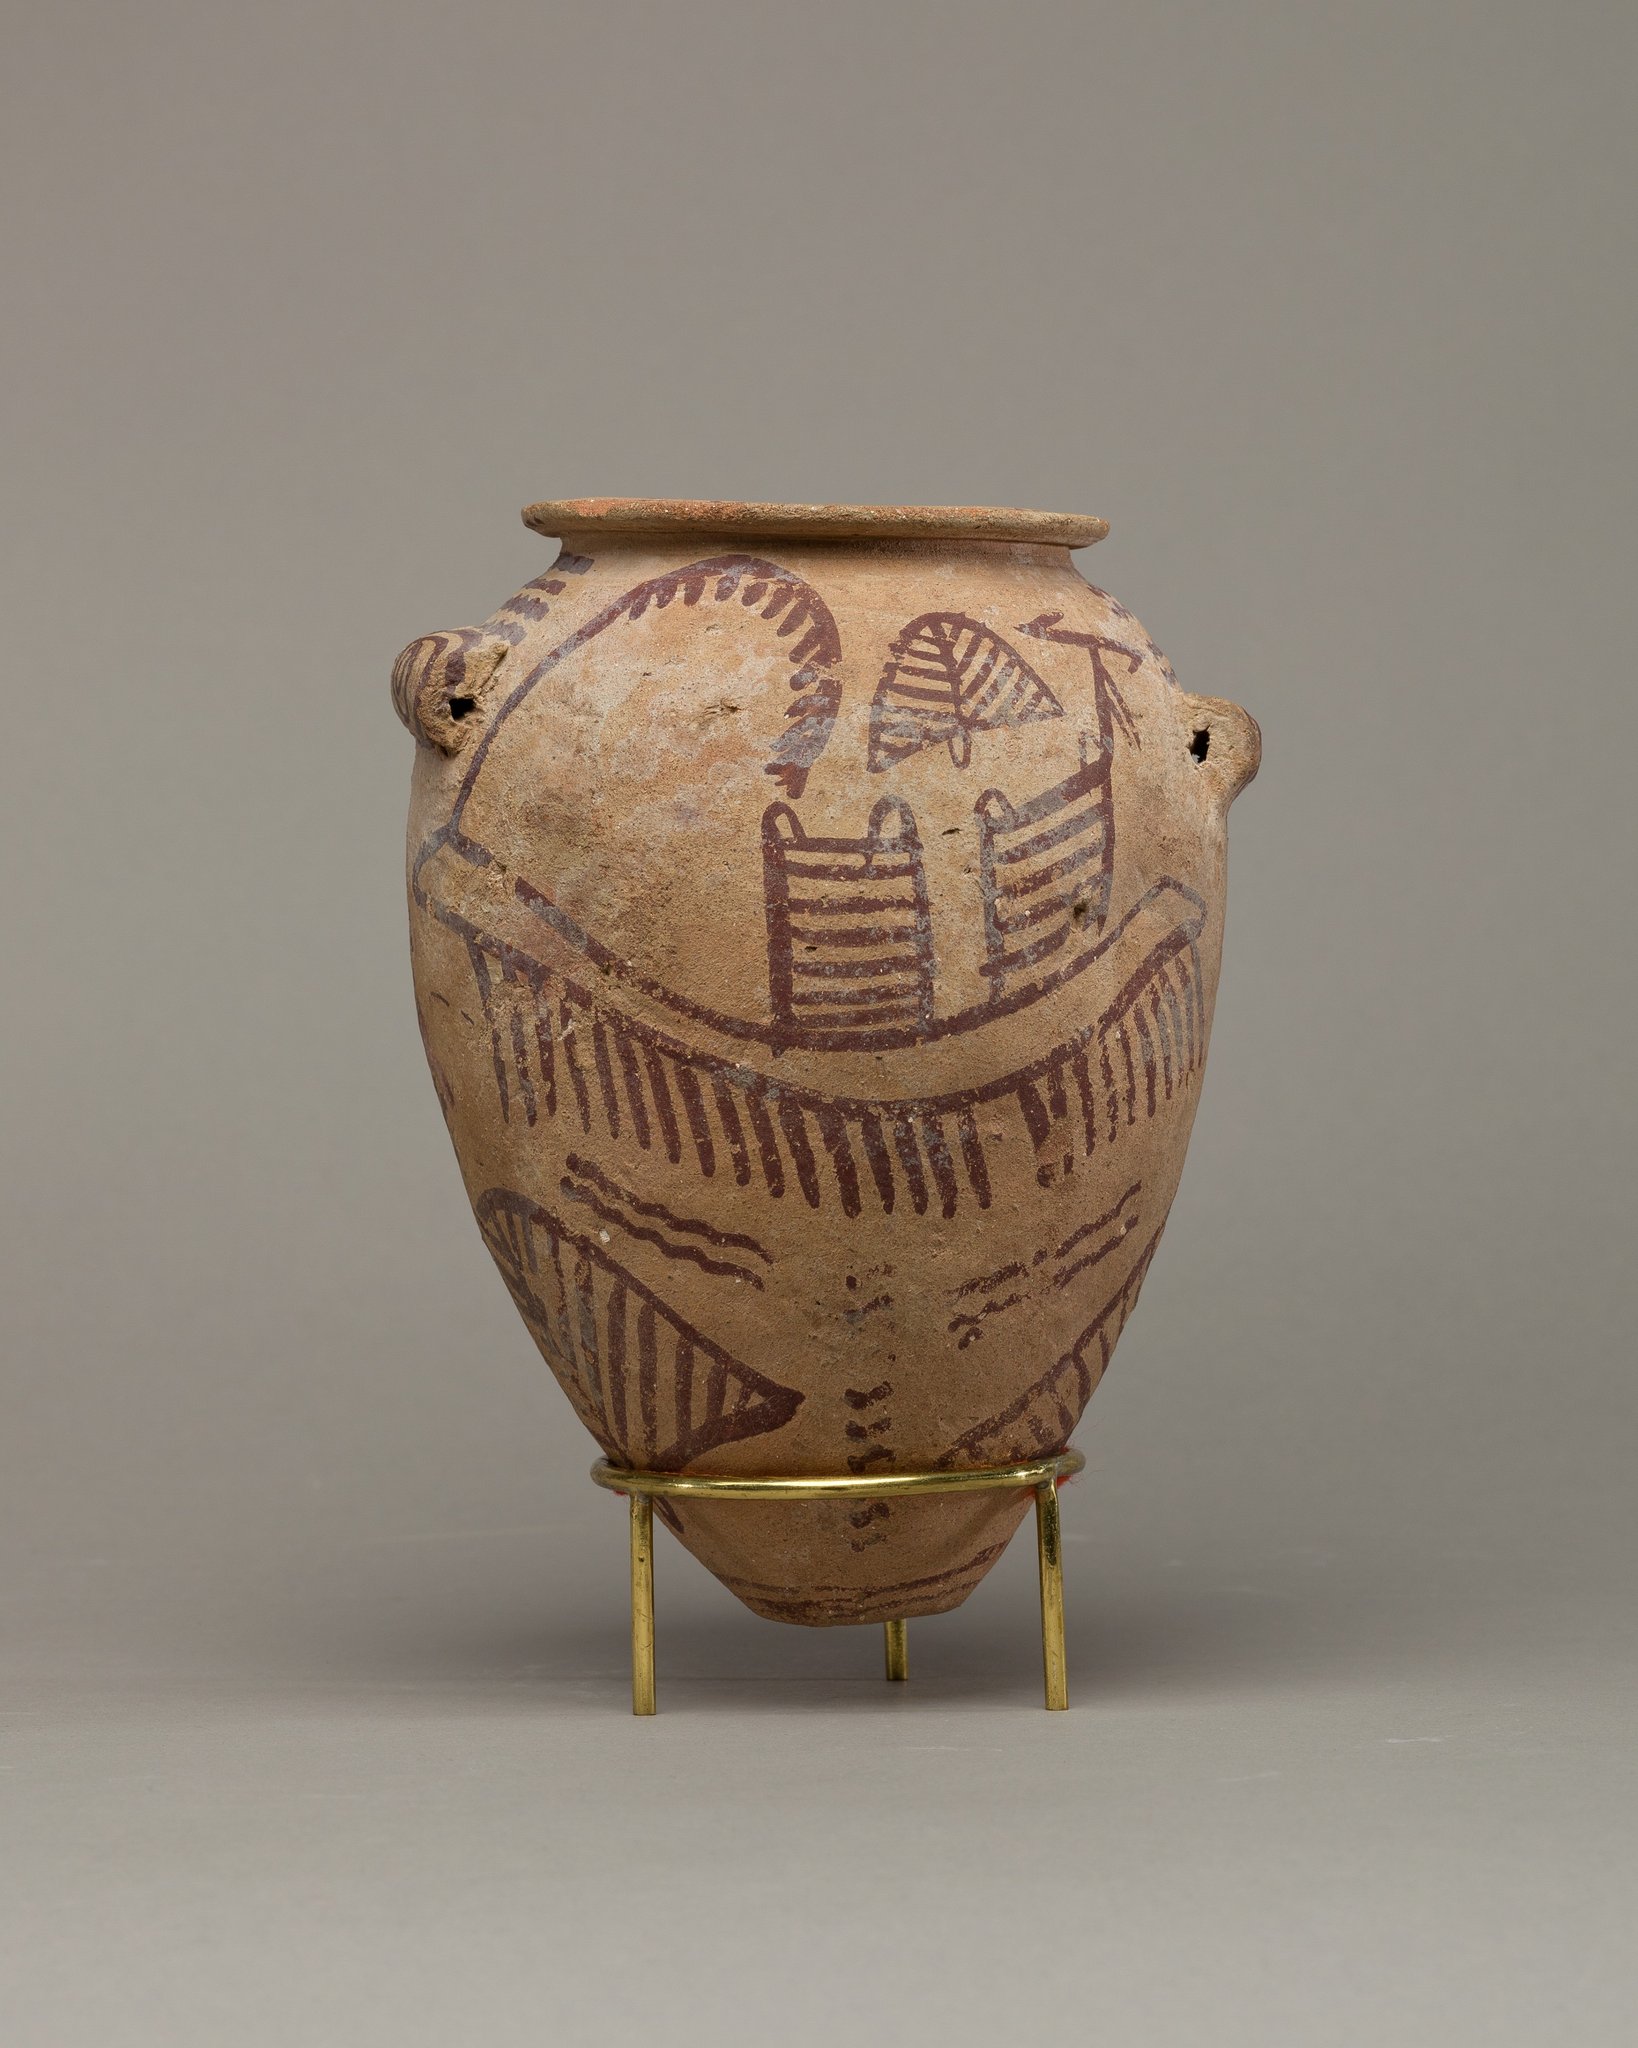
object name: jar, boat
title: Lugged jar depicting two boats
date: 4500-4000 BCE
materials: pottery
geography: egypt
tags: boats